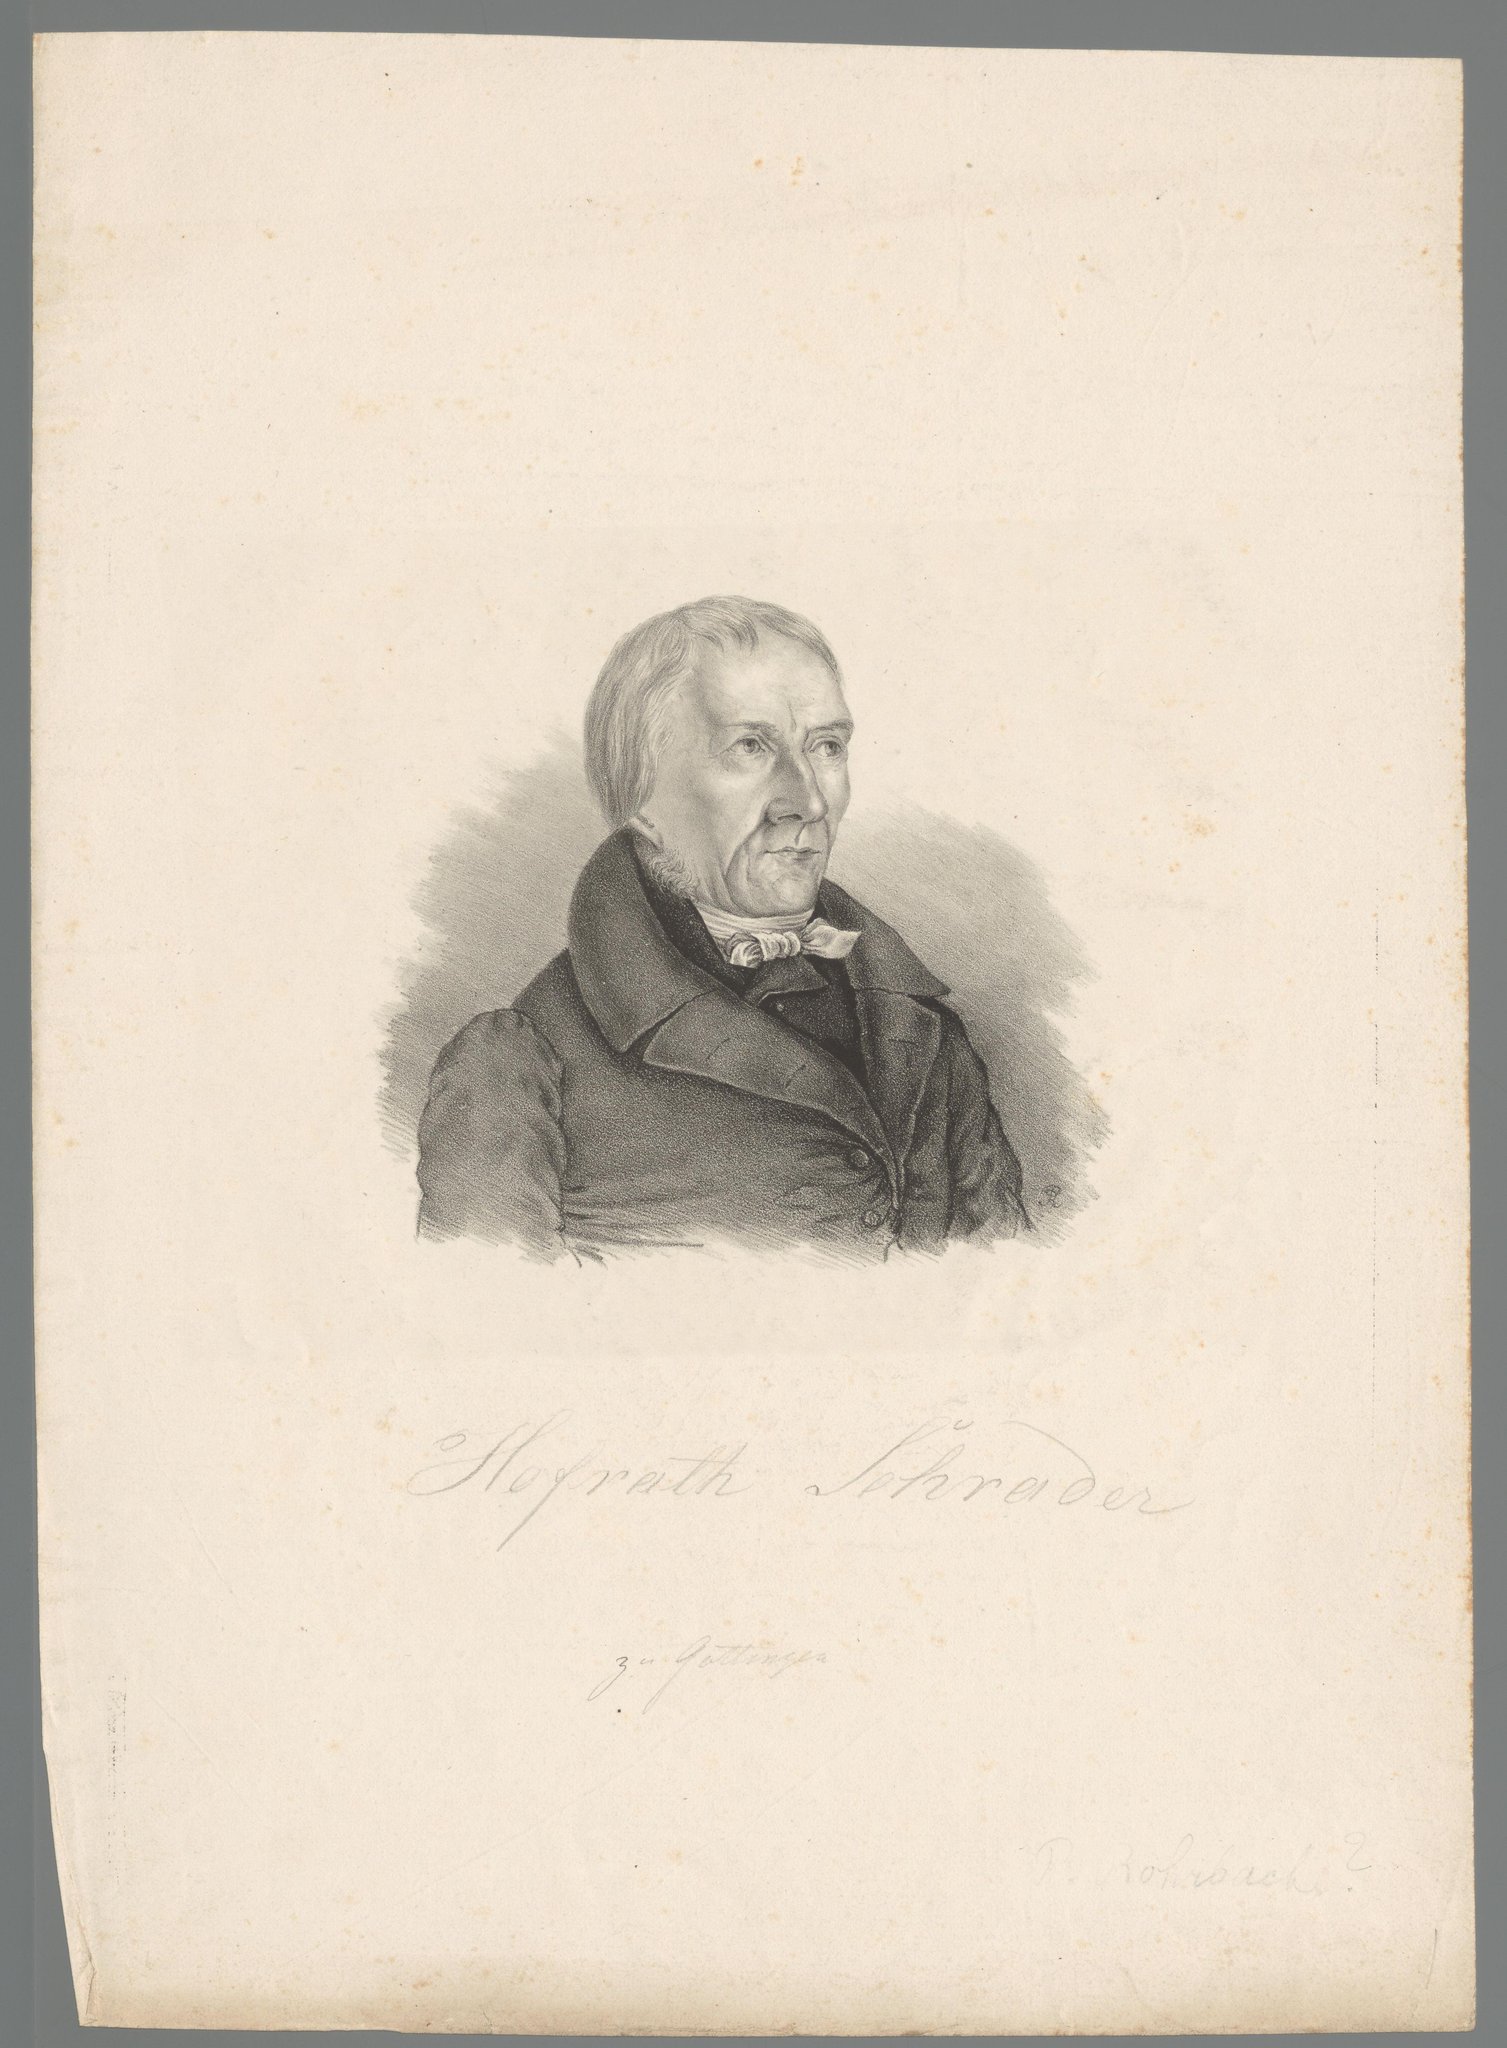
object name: print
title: Portret van Heinrich Adolf Schrader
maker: paul rohrbach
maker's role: print maker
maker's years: 1817-1862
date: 1827-1862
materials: paper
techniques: lithograph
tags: historical persons, physician, doctor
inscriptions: collector's mark: Lugt 2228